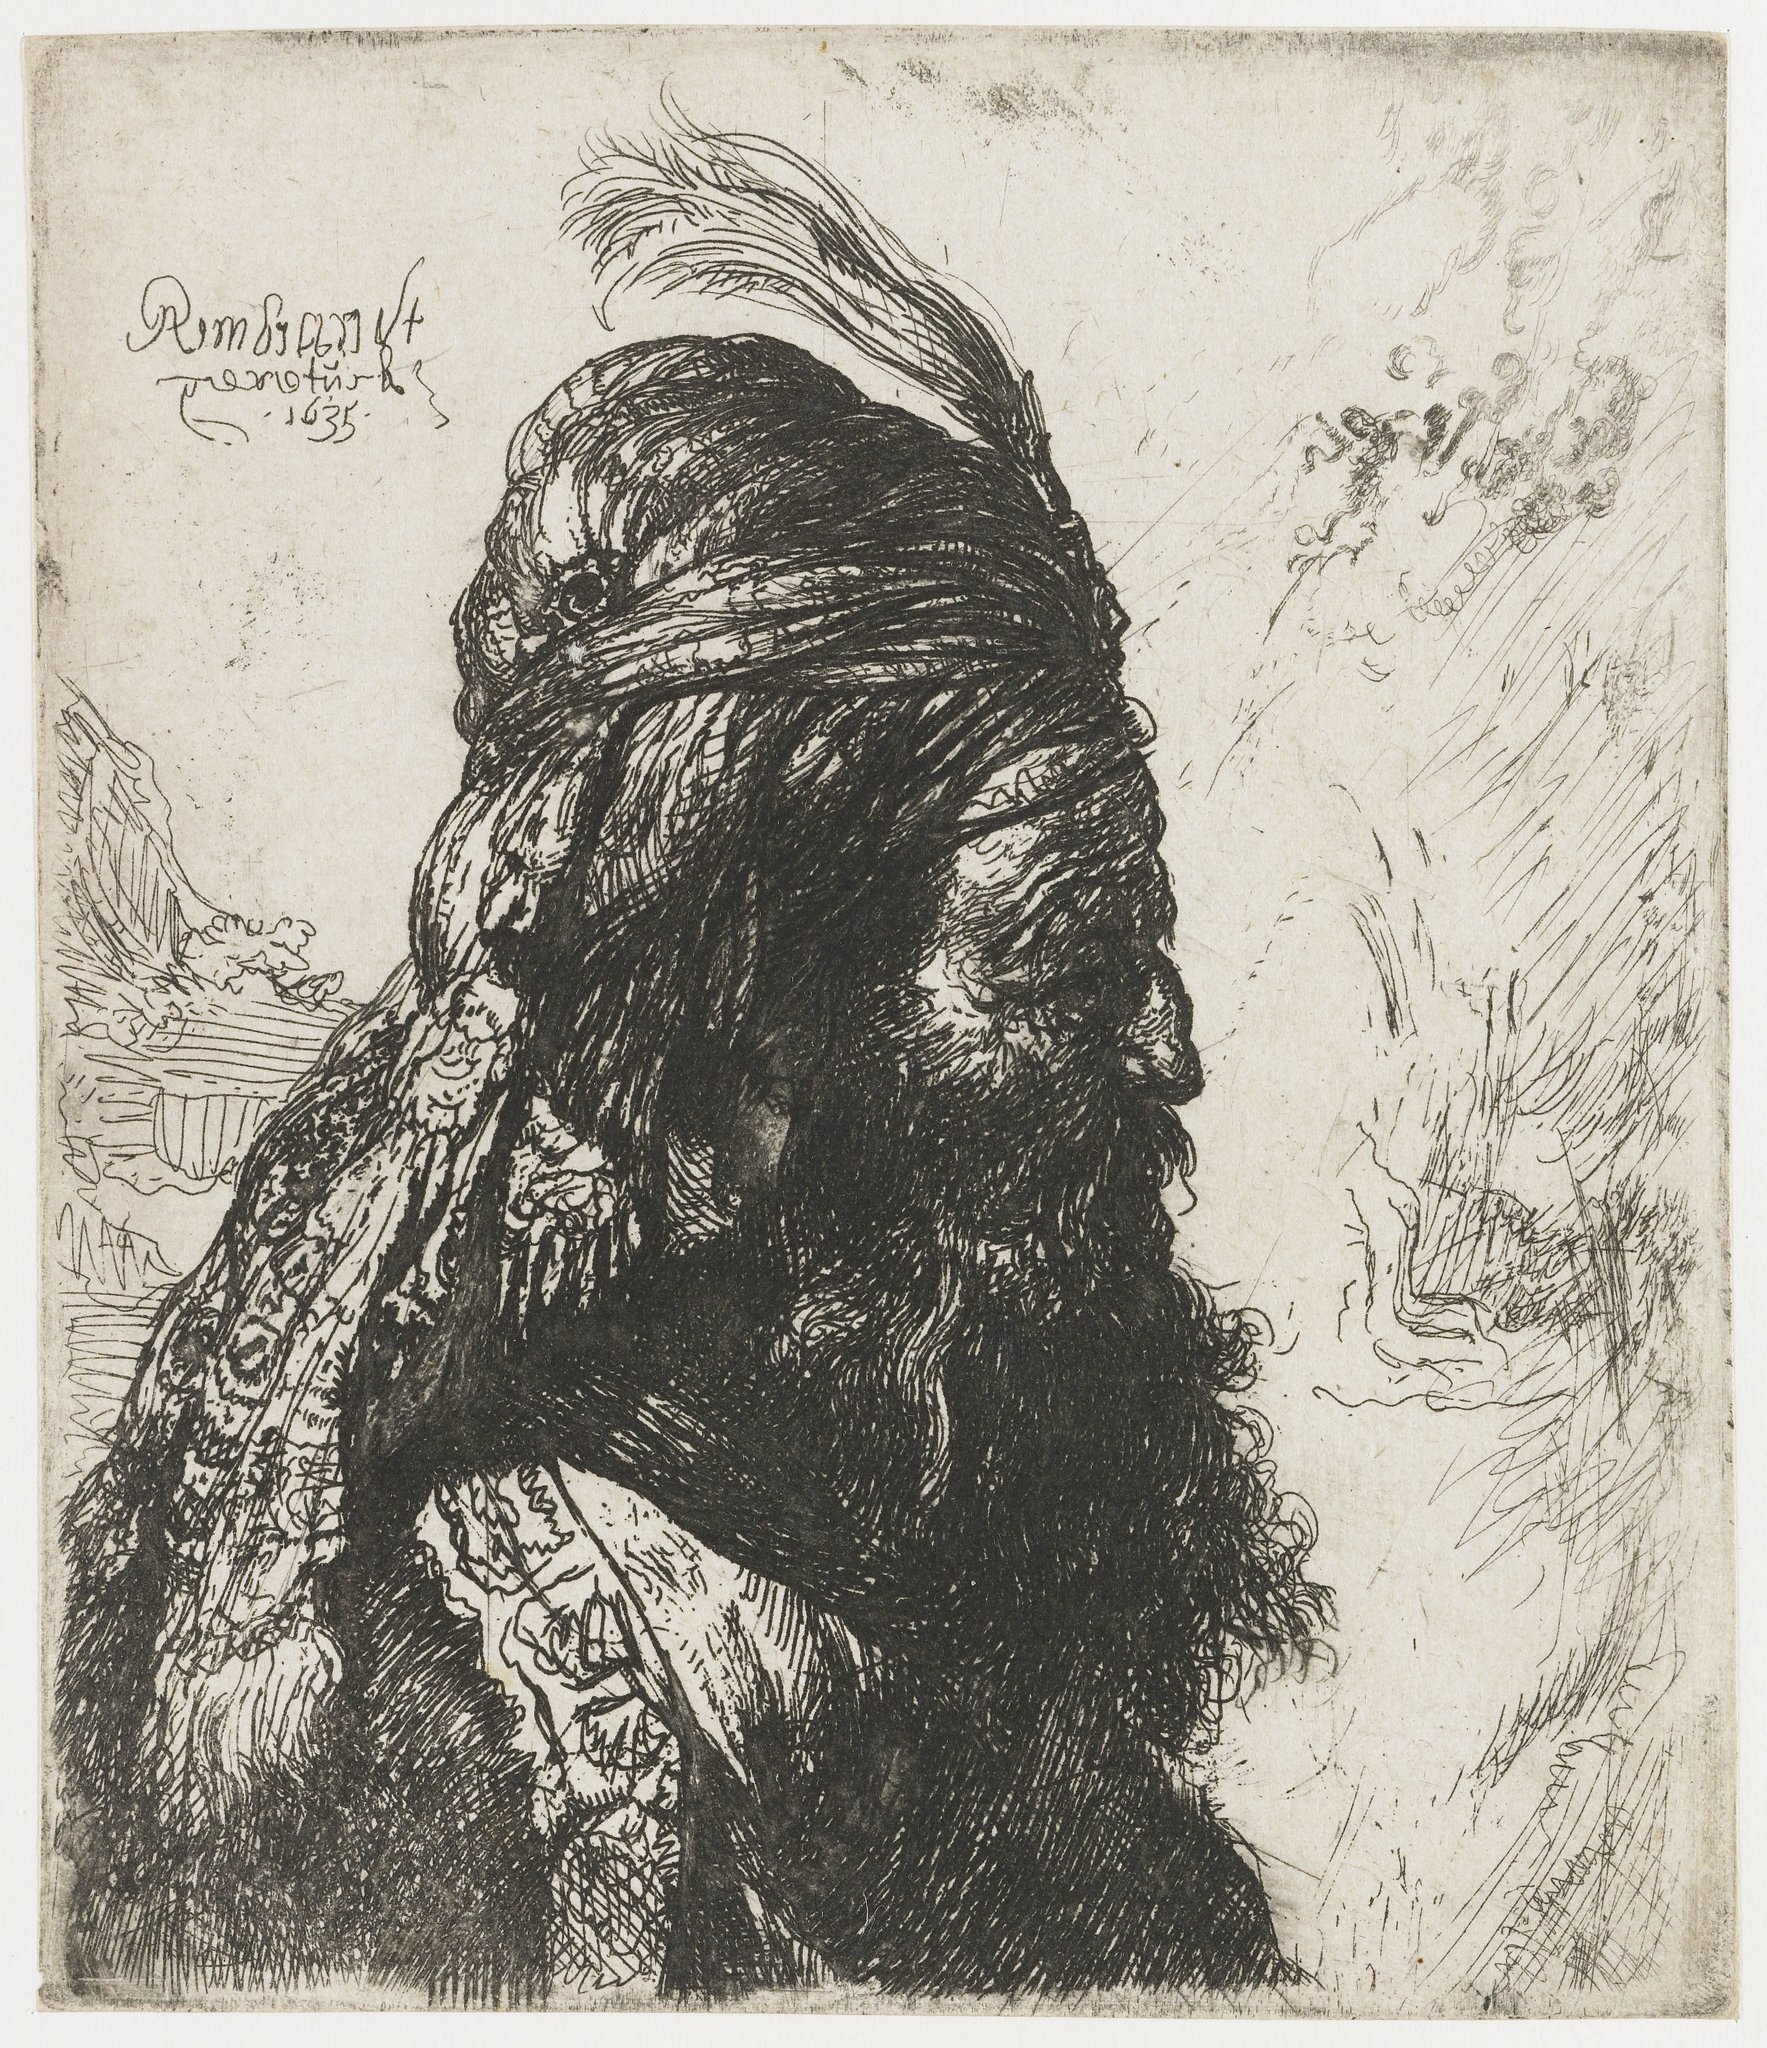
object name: print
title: The third Oriental head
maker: rembrandt van rijn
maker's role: draughtsman, painter, print maker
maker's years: 1606-1669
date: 1635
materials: paper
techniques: etching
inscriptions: signature and date: ‘Rembrandt geretuck 1635’, collector's mark: Lugt 2228, inscription: ‘This is the only original I have ever seen TP (?)’ Lugt 2451 a